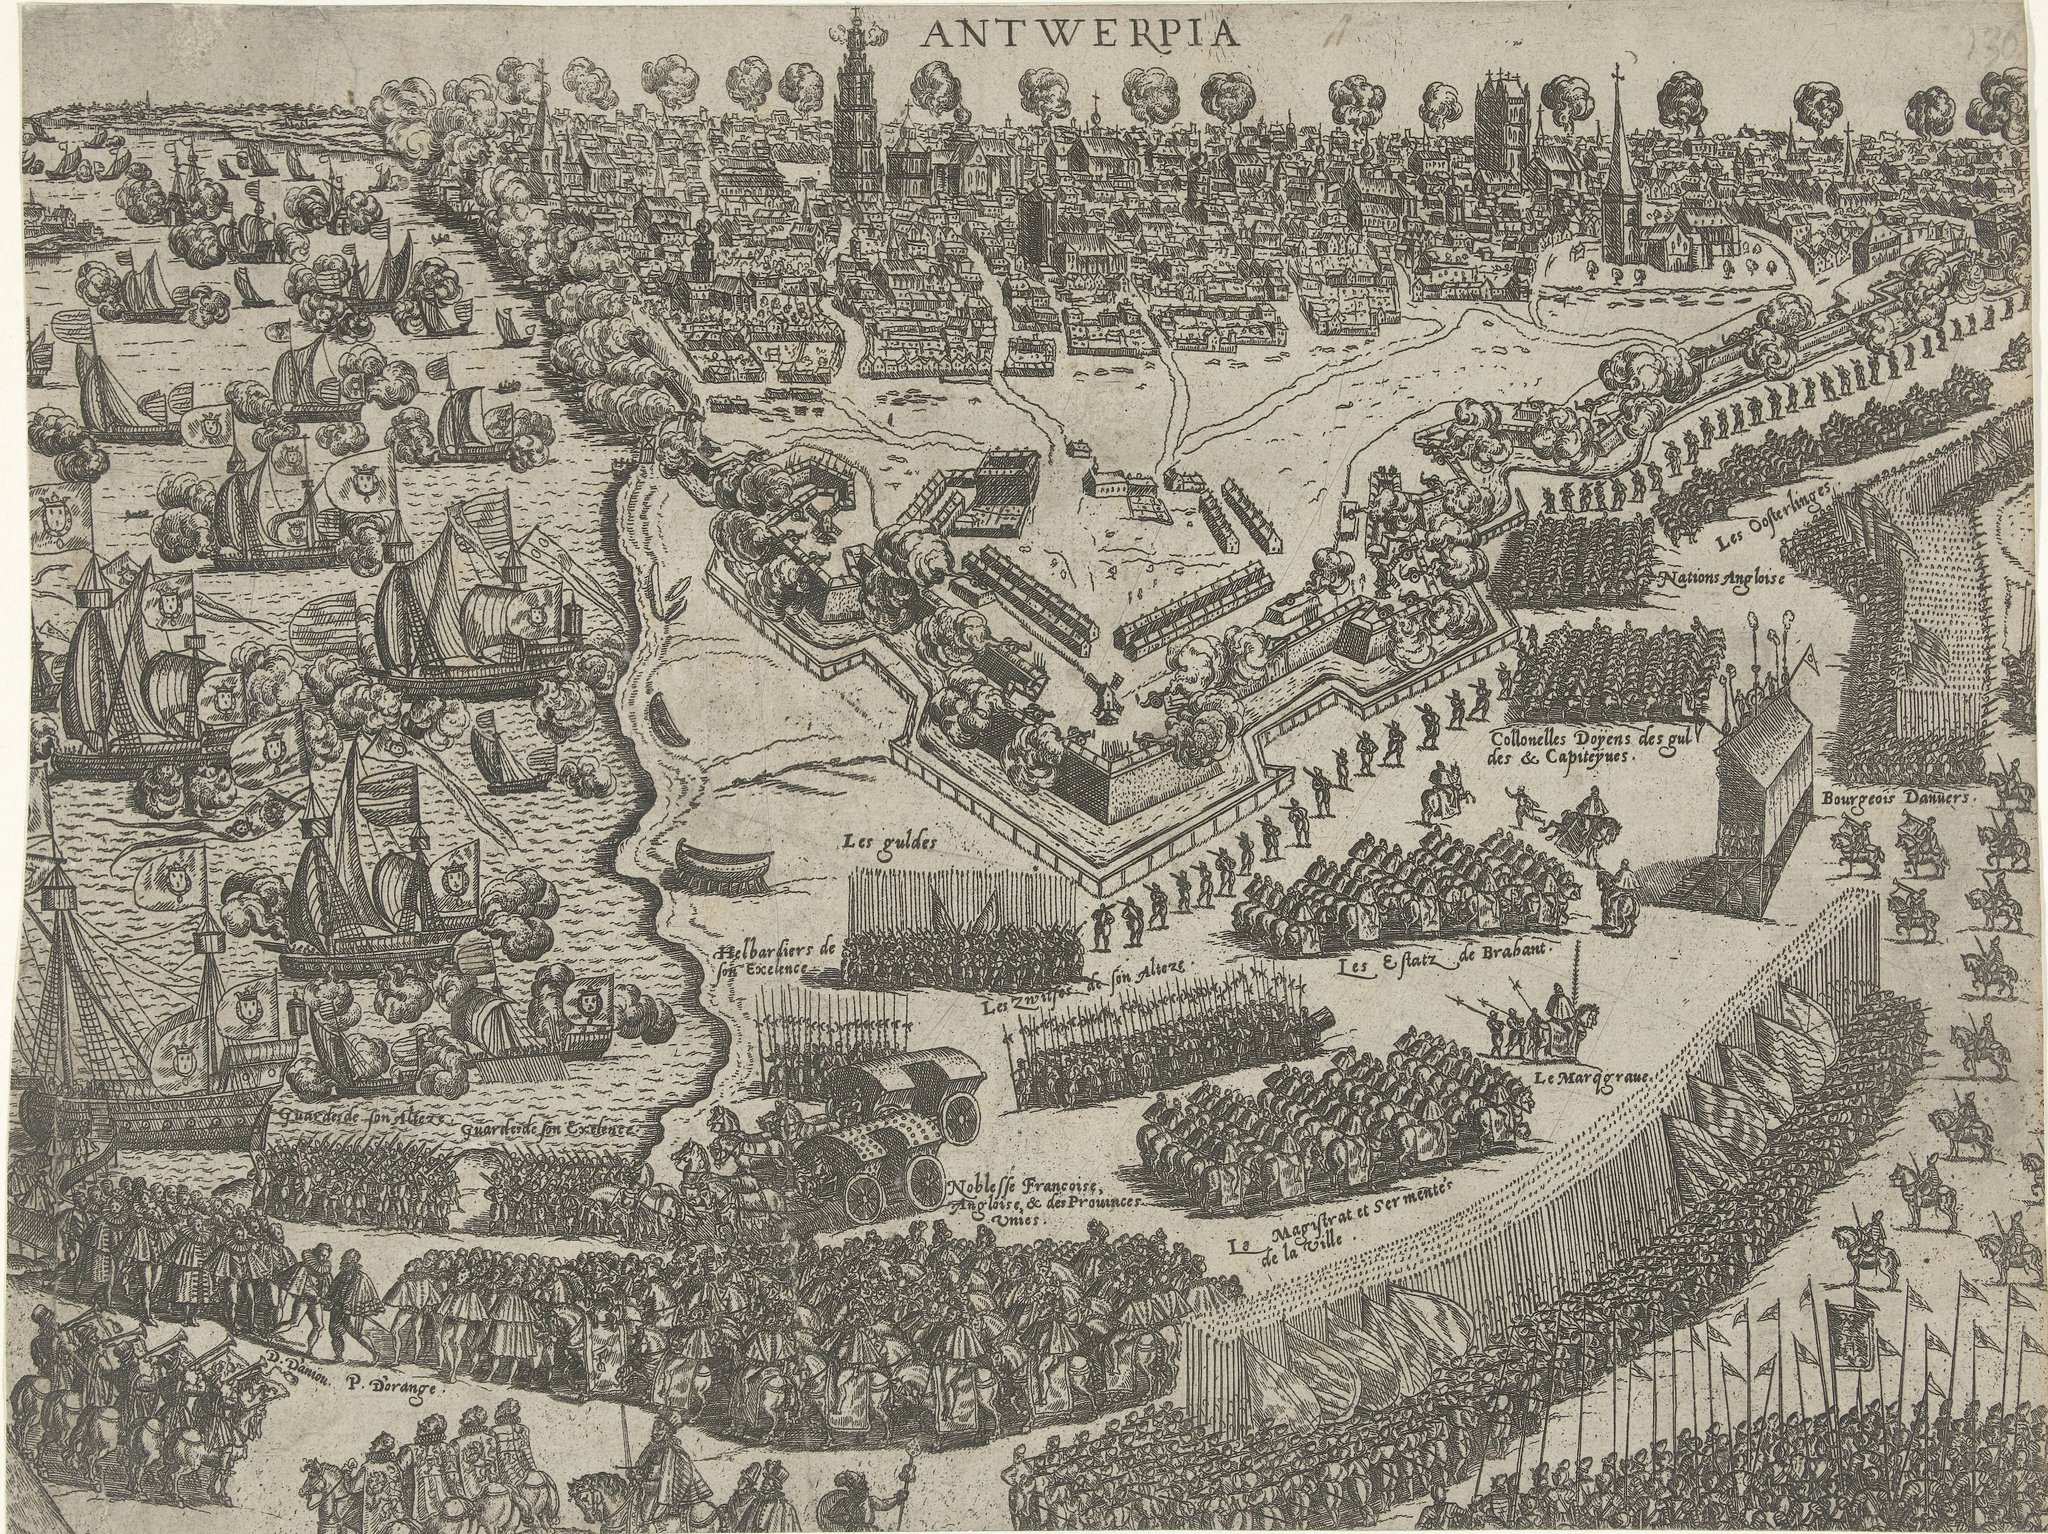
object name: print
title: Aankomst van de hertog van Anjou te Antwerpen en ontvangst door de prins van Oranje, 1582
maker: abraham de bruyn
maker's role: print maker, publisher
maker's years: 1540-1587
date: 1582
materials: paper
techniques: etching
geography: netherlands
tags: delft, william i (prince of orange), paris, françois-hercule de valois (hertog van anjou), triumphal entry and public reception, pageant, 'entrée solennelle', 'joyeuse entrée', antwerp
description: Aankomst van de hertog van Anjou te Antwerpen en ontvangst daar door de prins van Oranje, 19 februari 1582. Bovenaan over de gehele breedte de stad, links de Schelde. Onderaan links de ontmoeting van de prins en de hertog, waarbij een groot gevolg van edelen en krijgslieden te voet en te paard. In de Schelde vurende schepen en op de stadsmuren worden saluutschoten gelost. In de voorstelling opschriften in het Frans. Plaat I in de beschrijving van de intocht van de hertog van Anjou te Antwerpen, 19 februari 1582.